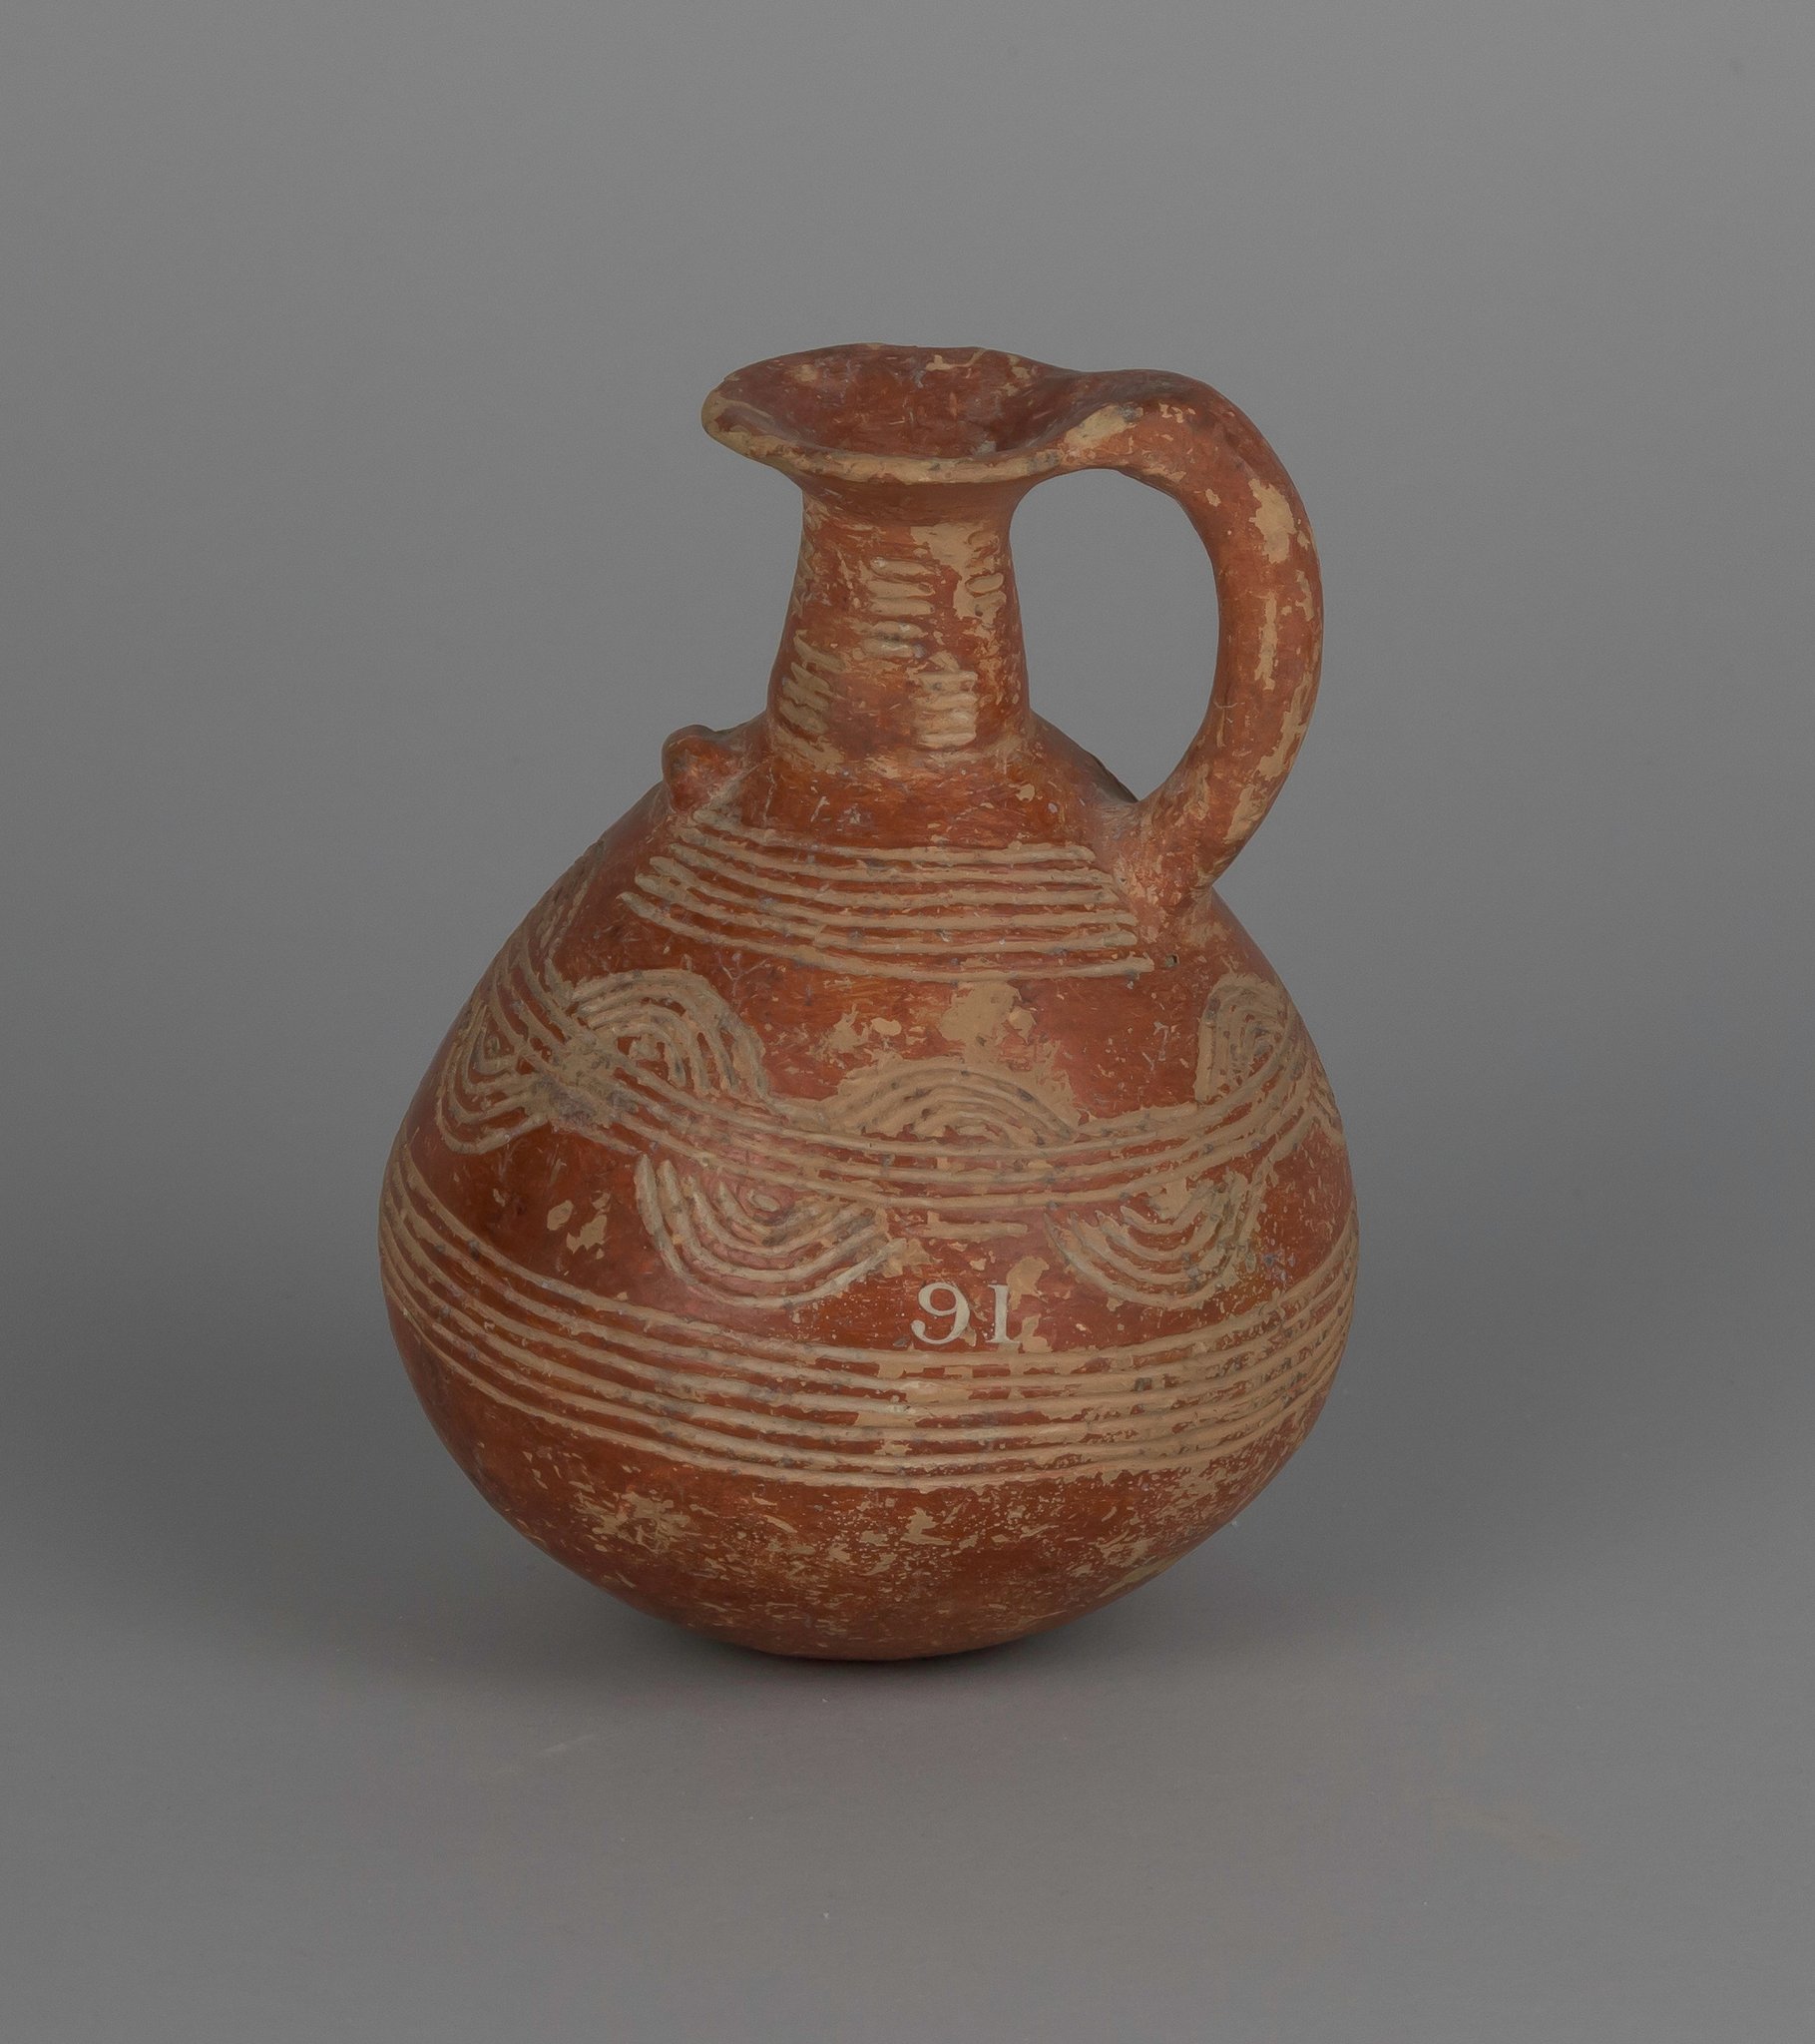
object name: juglet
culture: cypriot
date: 2500-1900 BCE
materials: terracotta